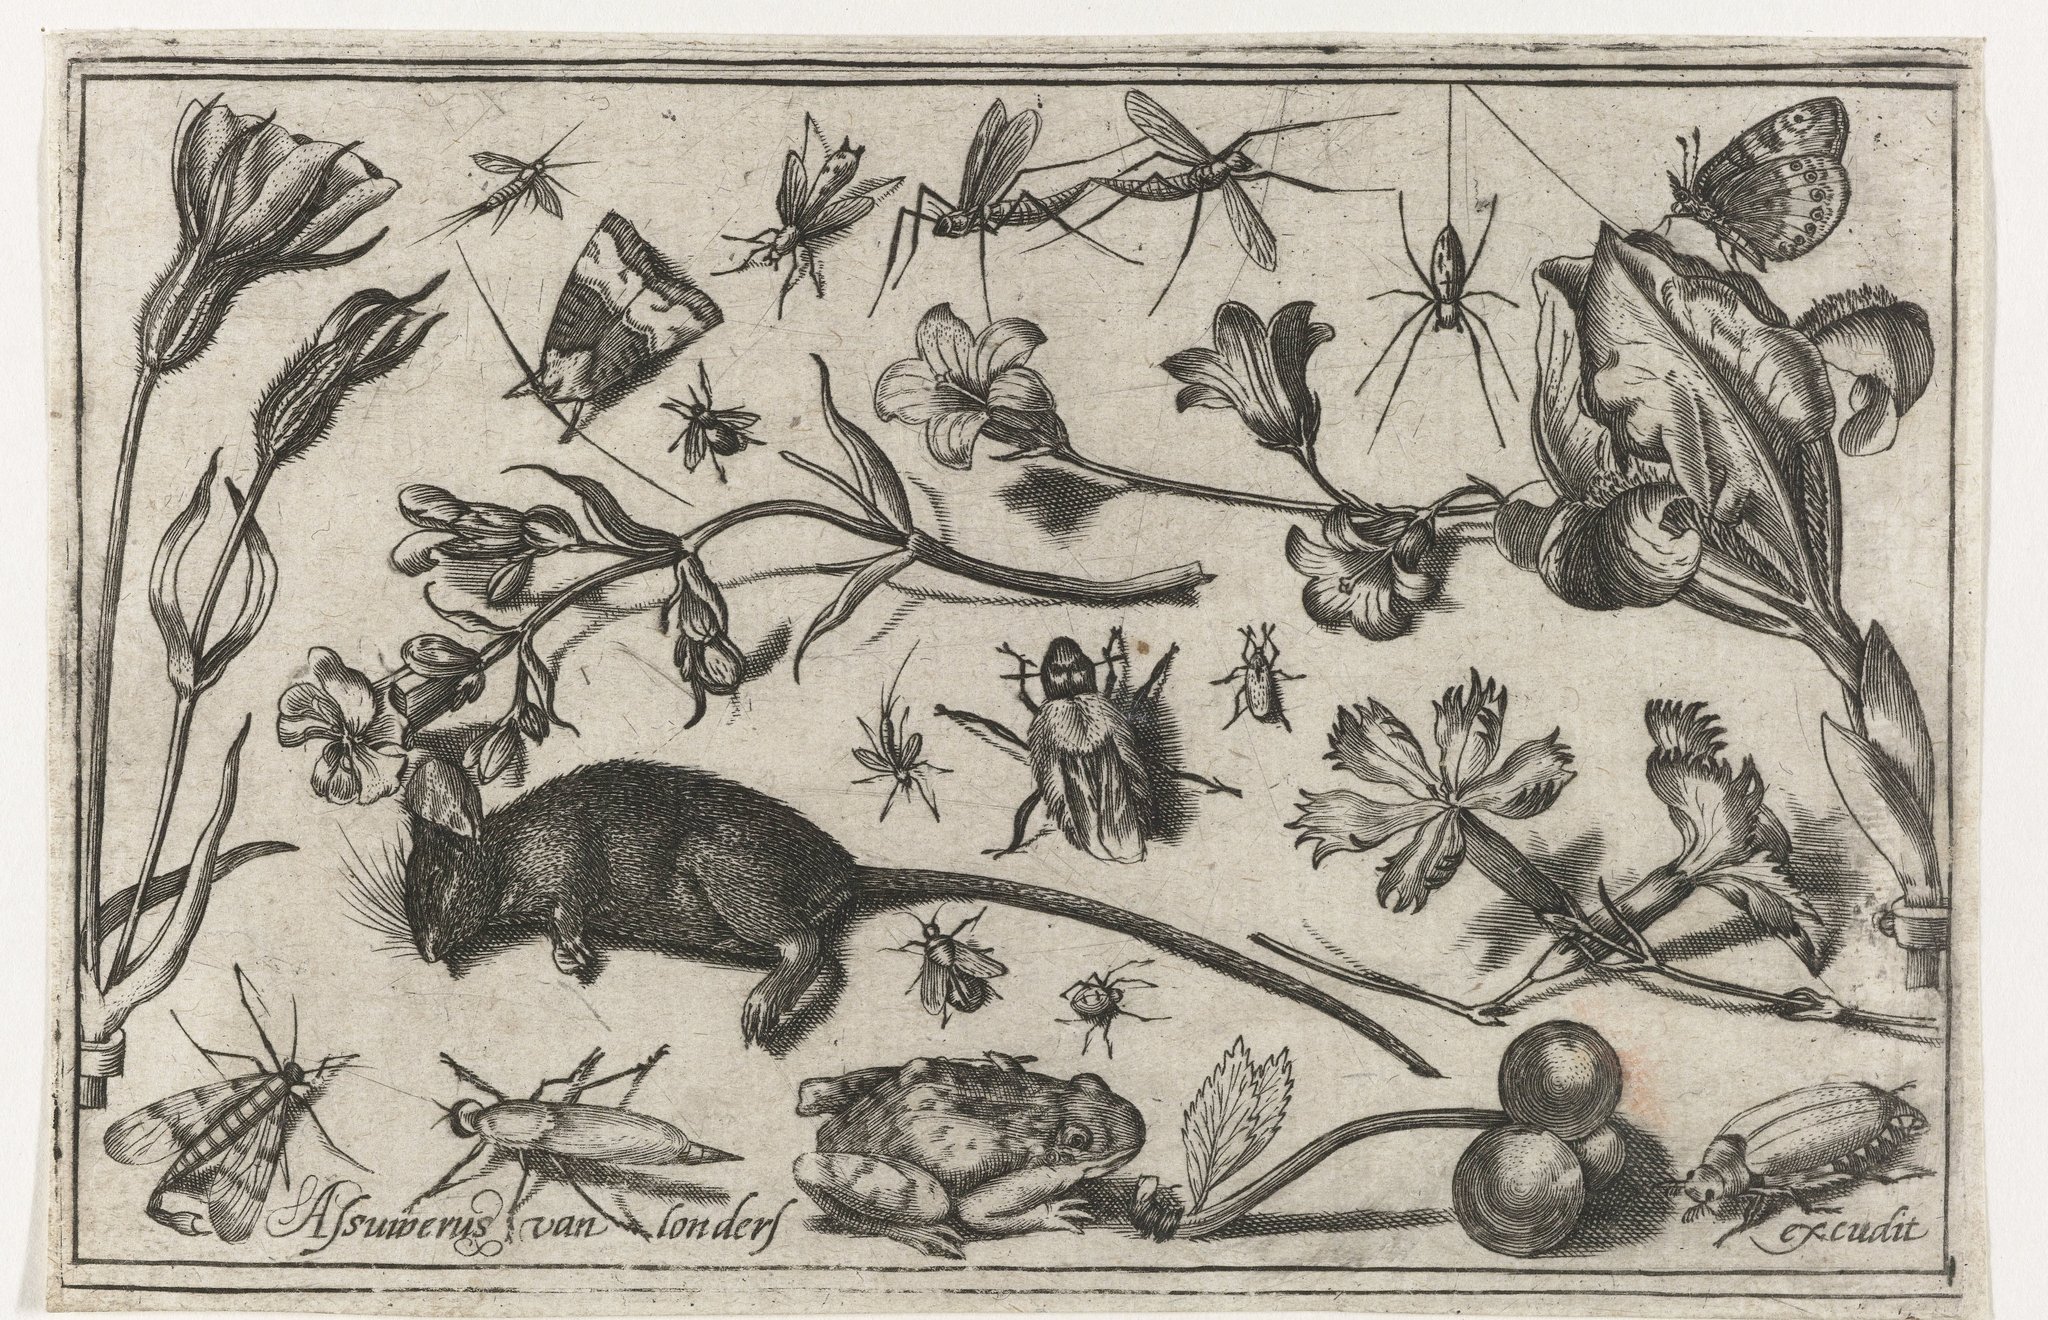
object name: print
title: Vogels, bloemen, insecten etc.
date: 1594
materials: paper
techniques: engraving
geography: netherlands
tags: flowers, rodents: mouse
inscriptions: collector's mark: Lugt 2228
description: Prent uit serie van onbekend aantal prenten met onder andere vogels, bloemen en insecten.